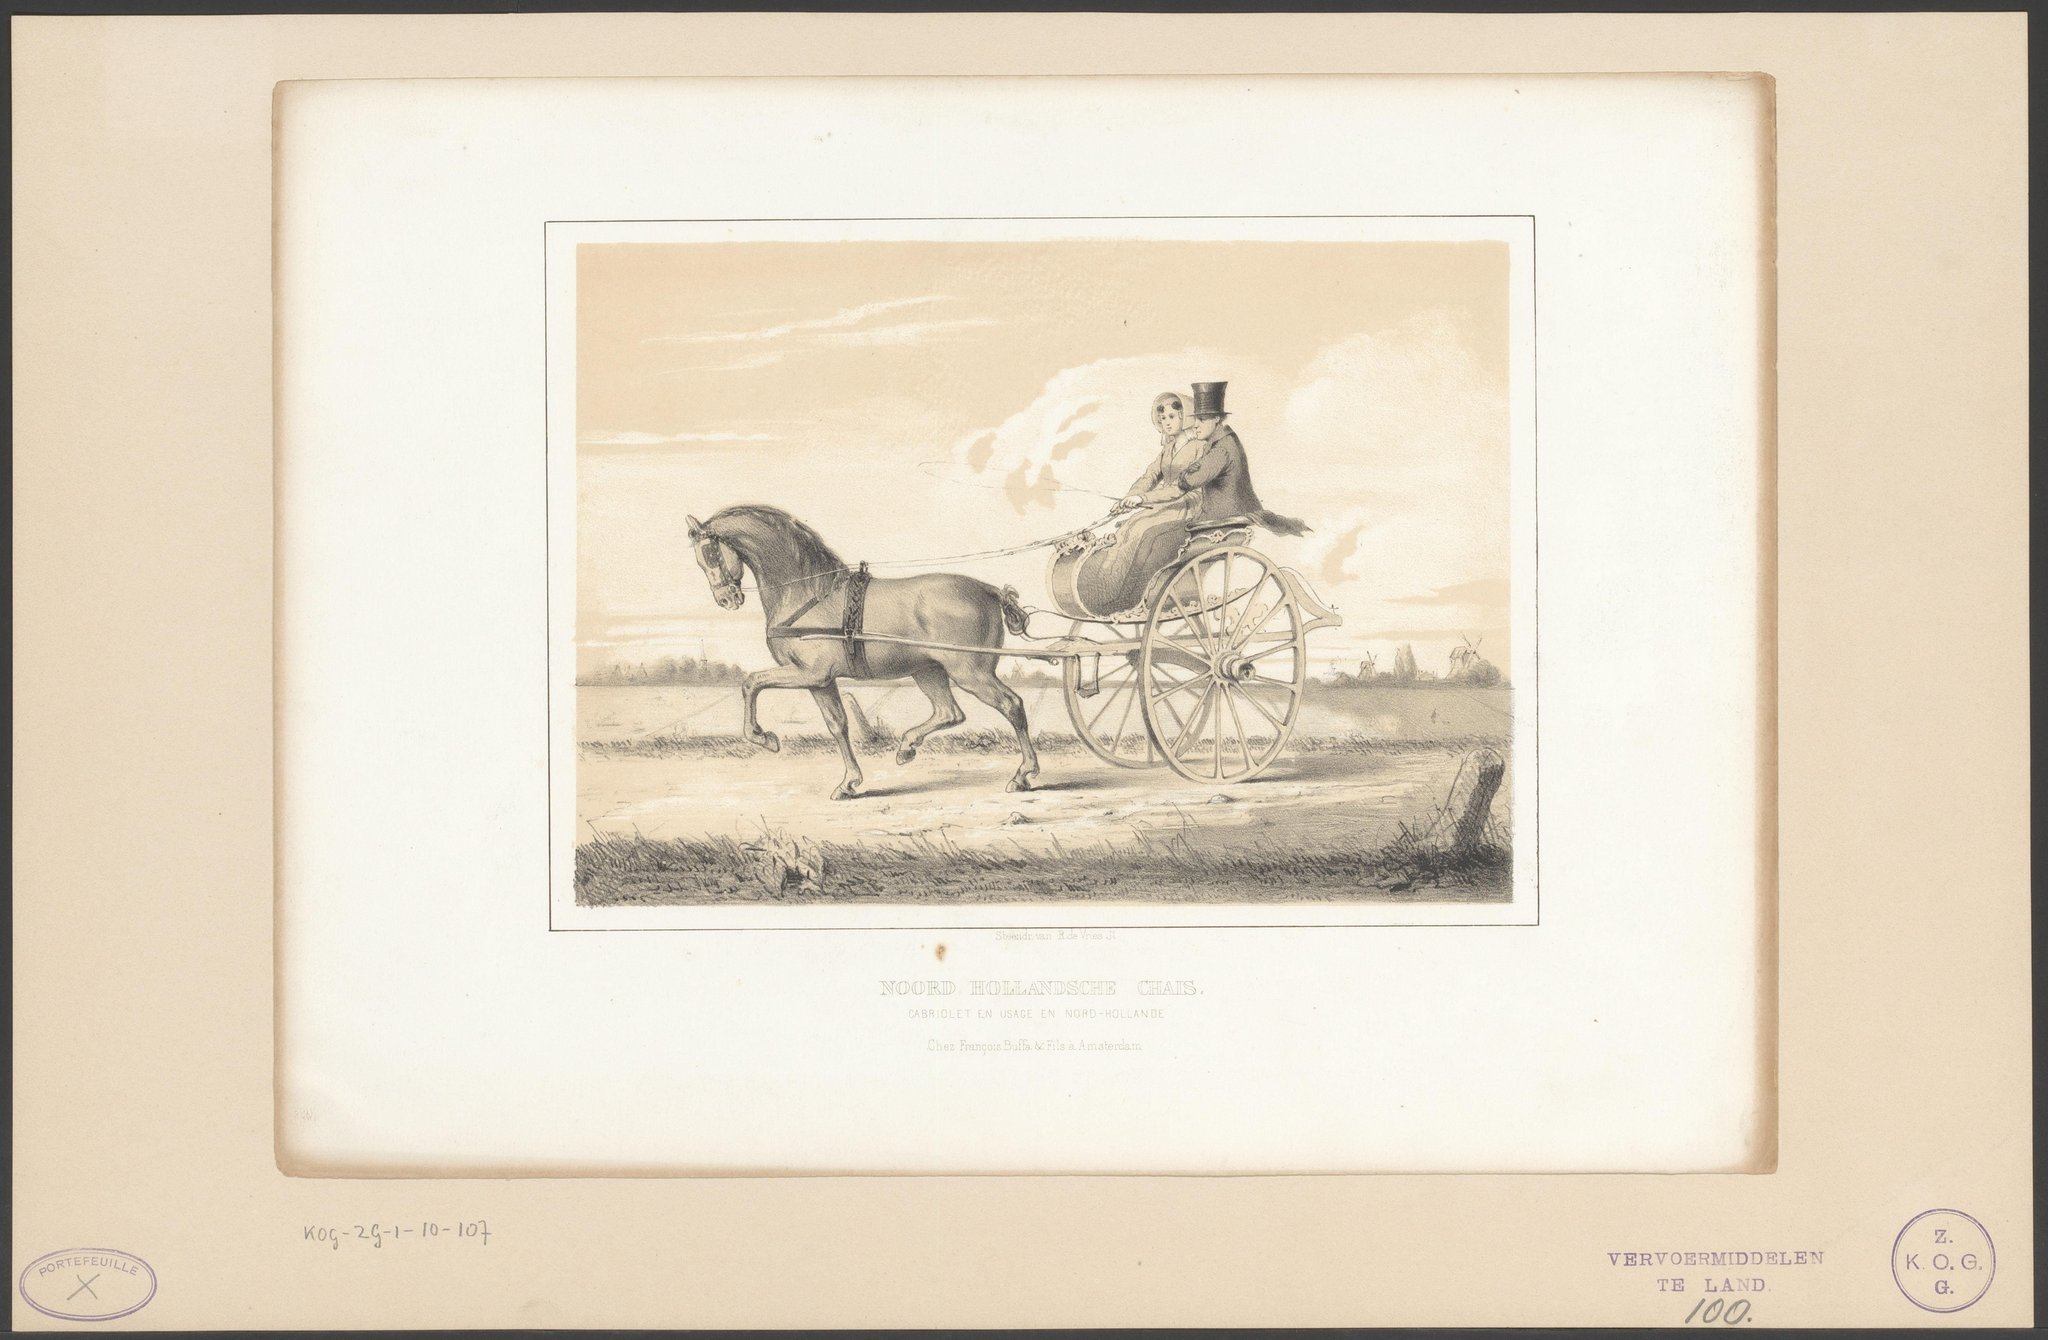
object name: print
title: Noord-Hollandse sjees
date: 1813-1874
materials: paper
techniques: tone lithography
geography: amsterdam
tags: two-wheeled vehicle drawn by one animal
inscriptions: stamp, collector's mark: Lugt 1641, stamp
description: Noord-Hollandse sjees rijdt mogelijk langs de Zaan. Onderwerpsrubrieken binnen de Atlas Zeden en Gewoonten: Handel, nijverheid en verkeer, Vervoermiddelen te land en te water, vervoermiddelen te land, Sjeezen en Boerenwagens.